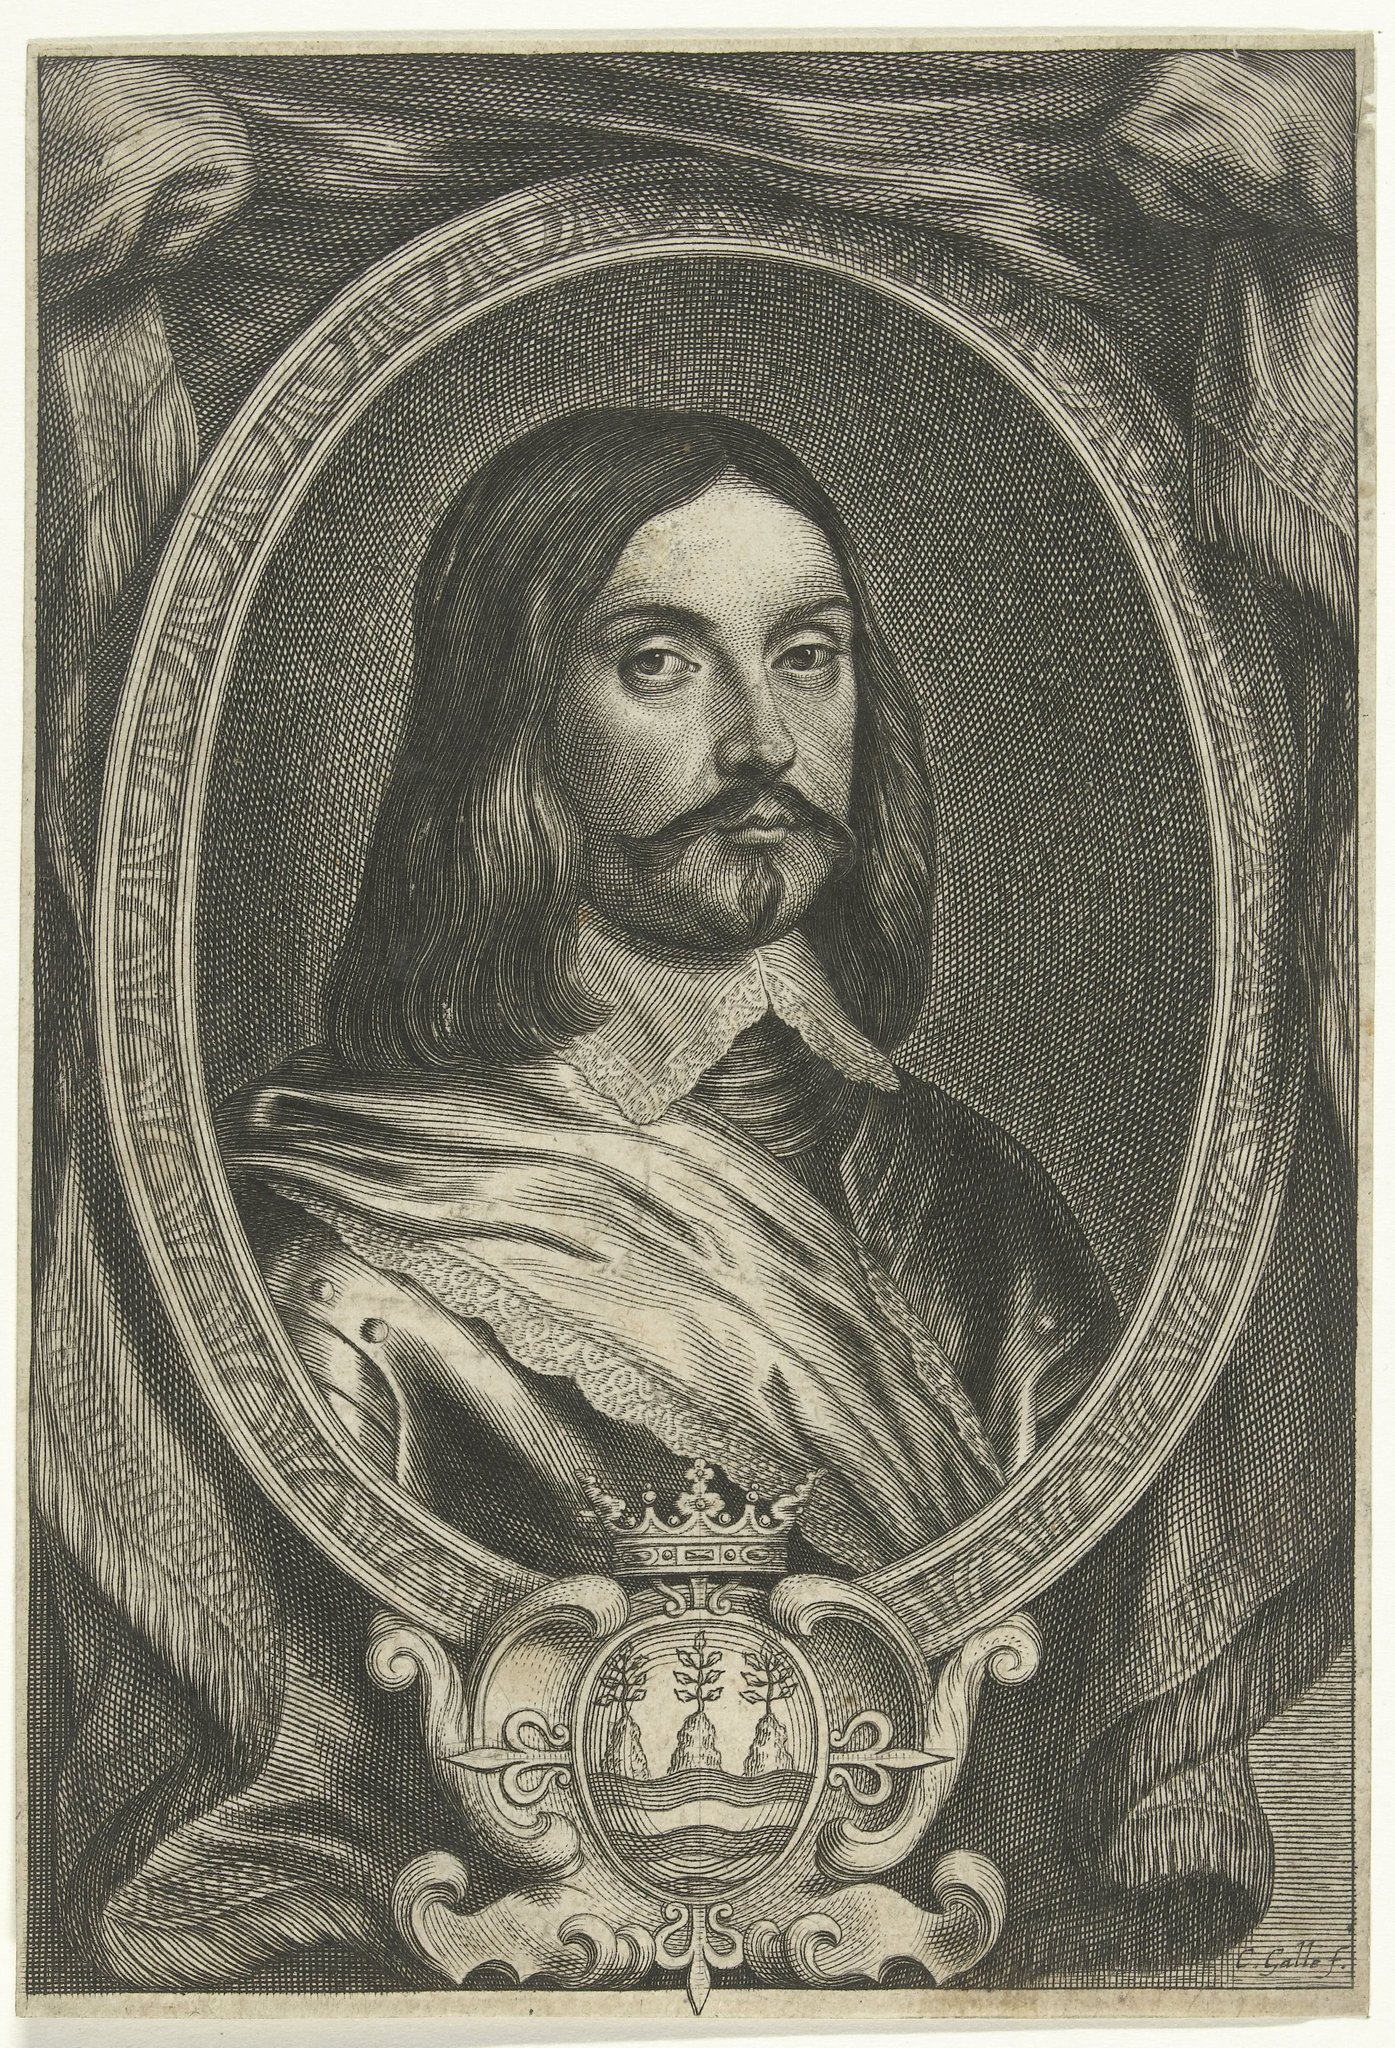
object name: print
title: Portret van Alonso Pérez de Vivero y Menchaca, graaf van Fuensaldaña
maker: cornelis galle (ii)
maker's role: print maker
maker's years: 1615-1678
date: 1638-1678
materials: paper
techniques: engraving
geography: antwerp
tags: earl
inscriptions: collector's mark: Lugt 2228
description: Portret van Alonso Pérez de Vivero y Menchaca, graaf van Fuensaldaña, in ovaal met draperie. Onder het portret zijn familiewapen met drie heuvels met bomen.